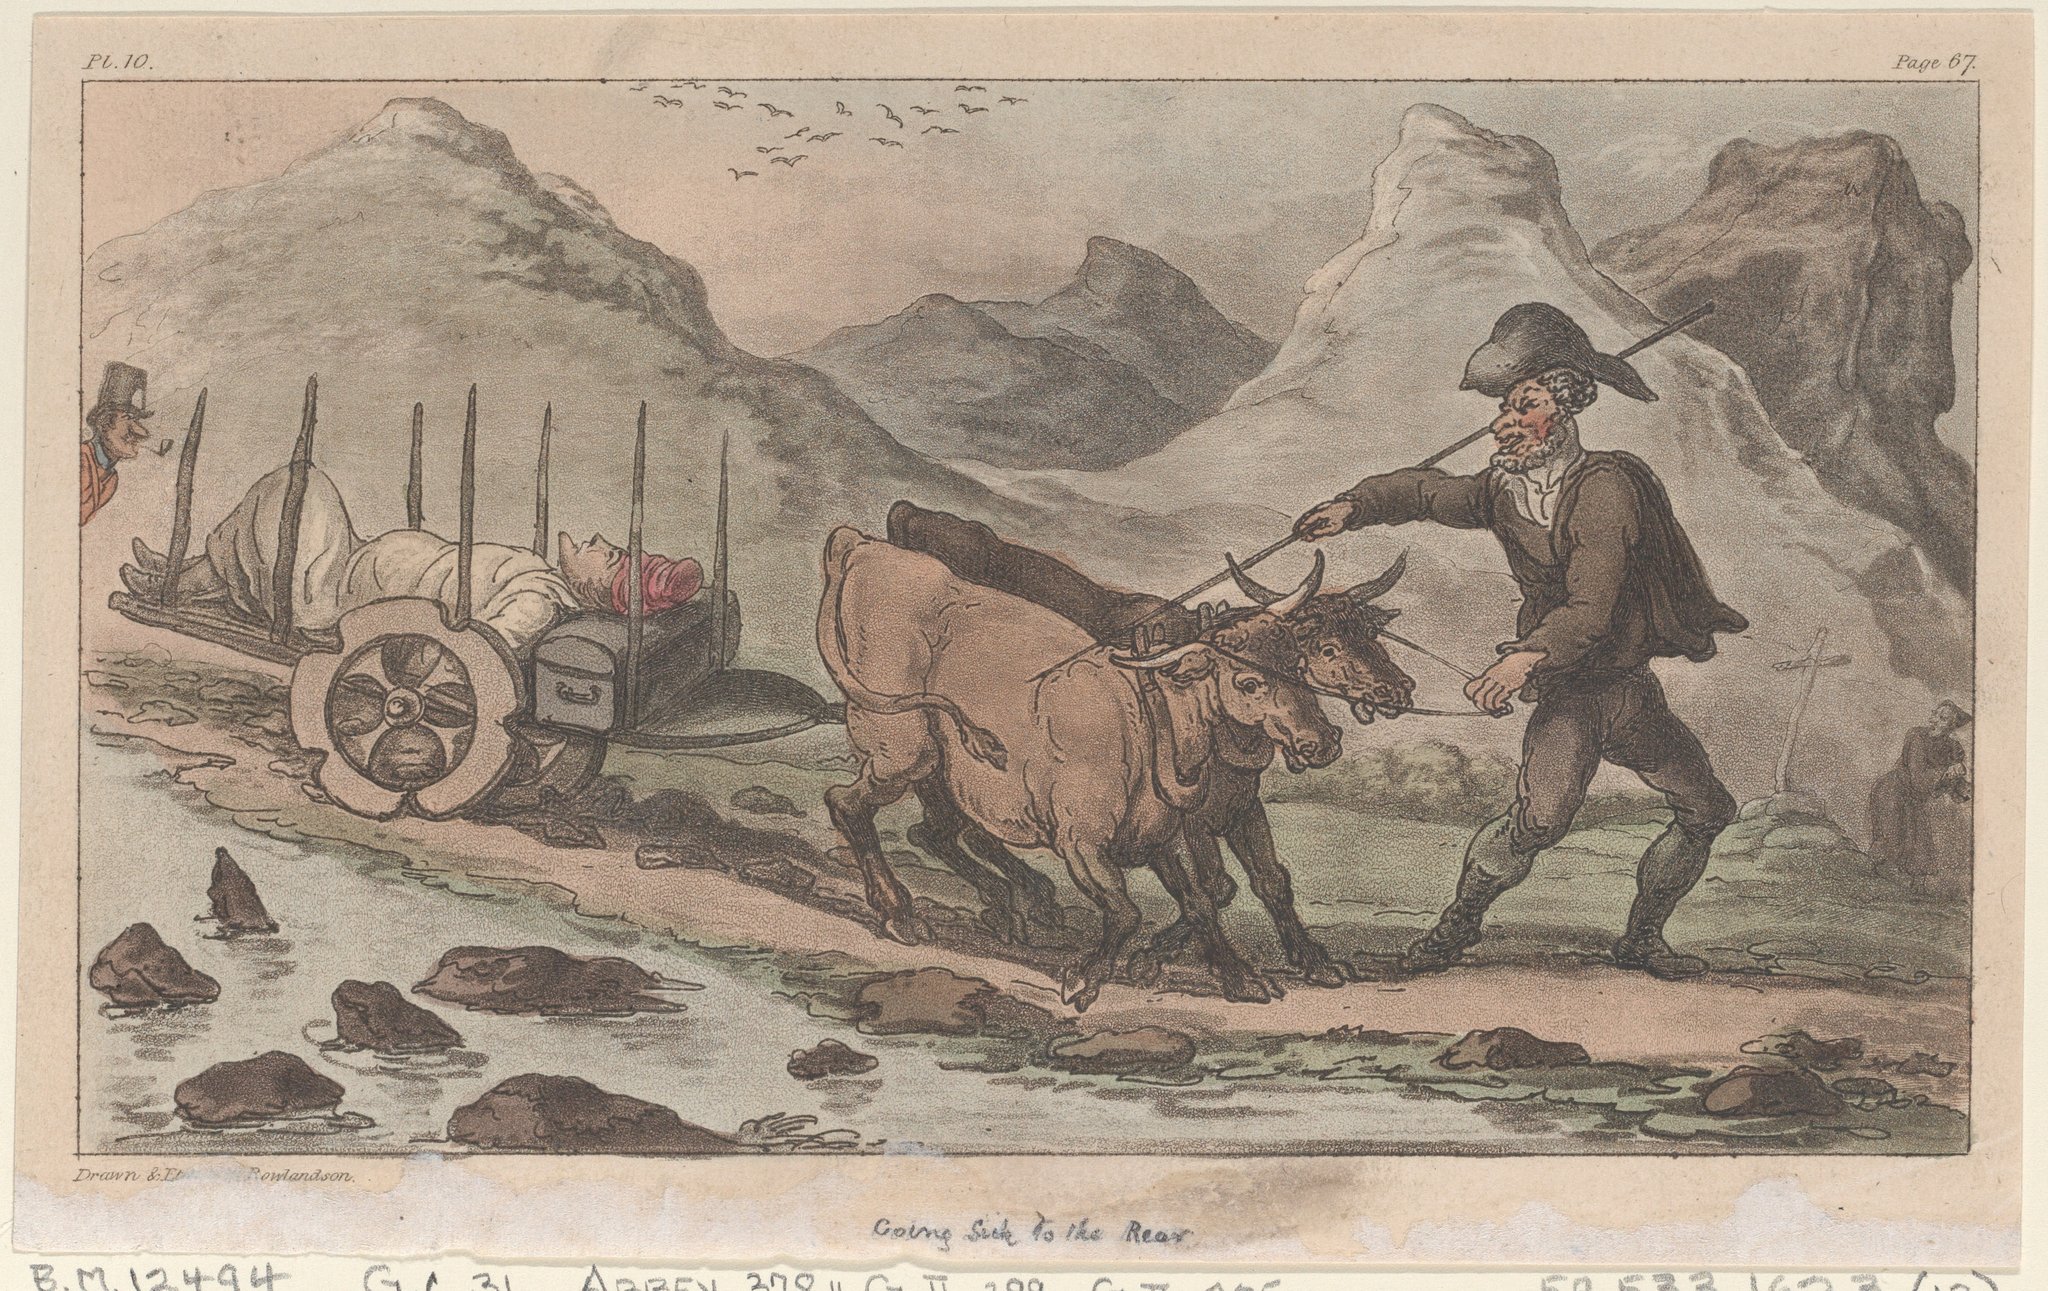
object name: print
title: Going sick to the rear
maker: thomas rowlandson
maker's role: artist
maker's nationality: british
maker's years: 1757-1827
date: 1815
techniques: aquatint, etching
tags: men,carts,ox